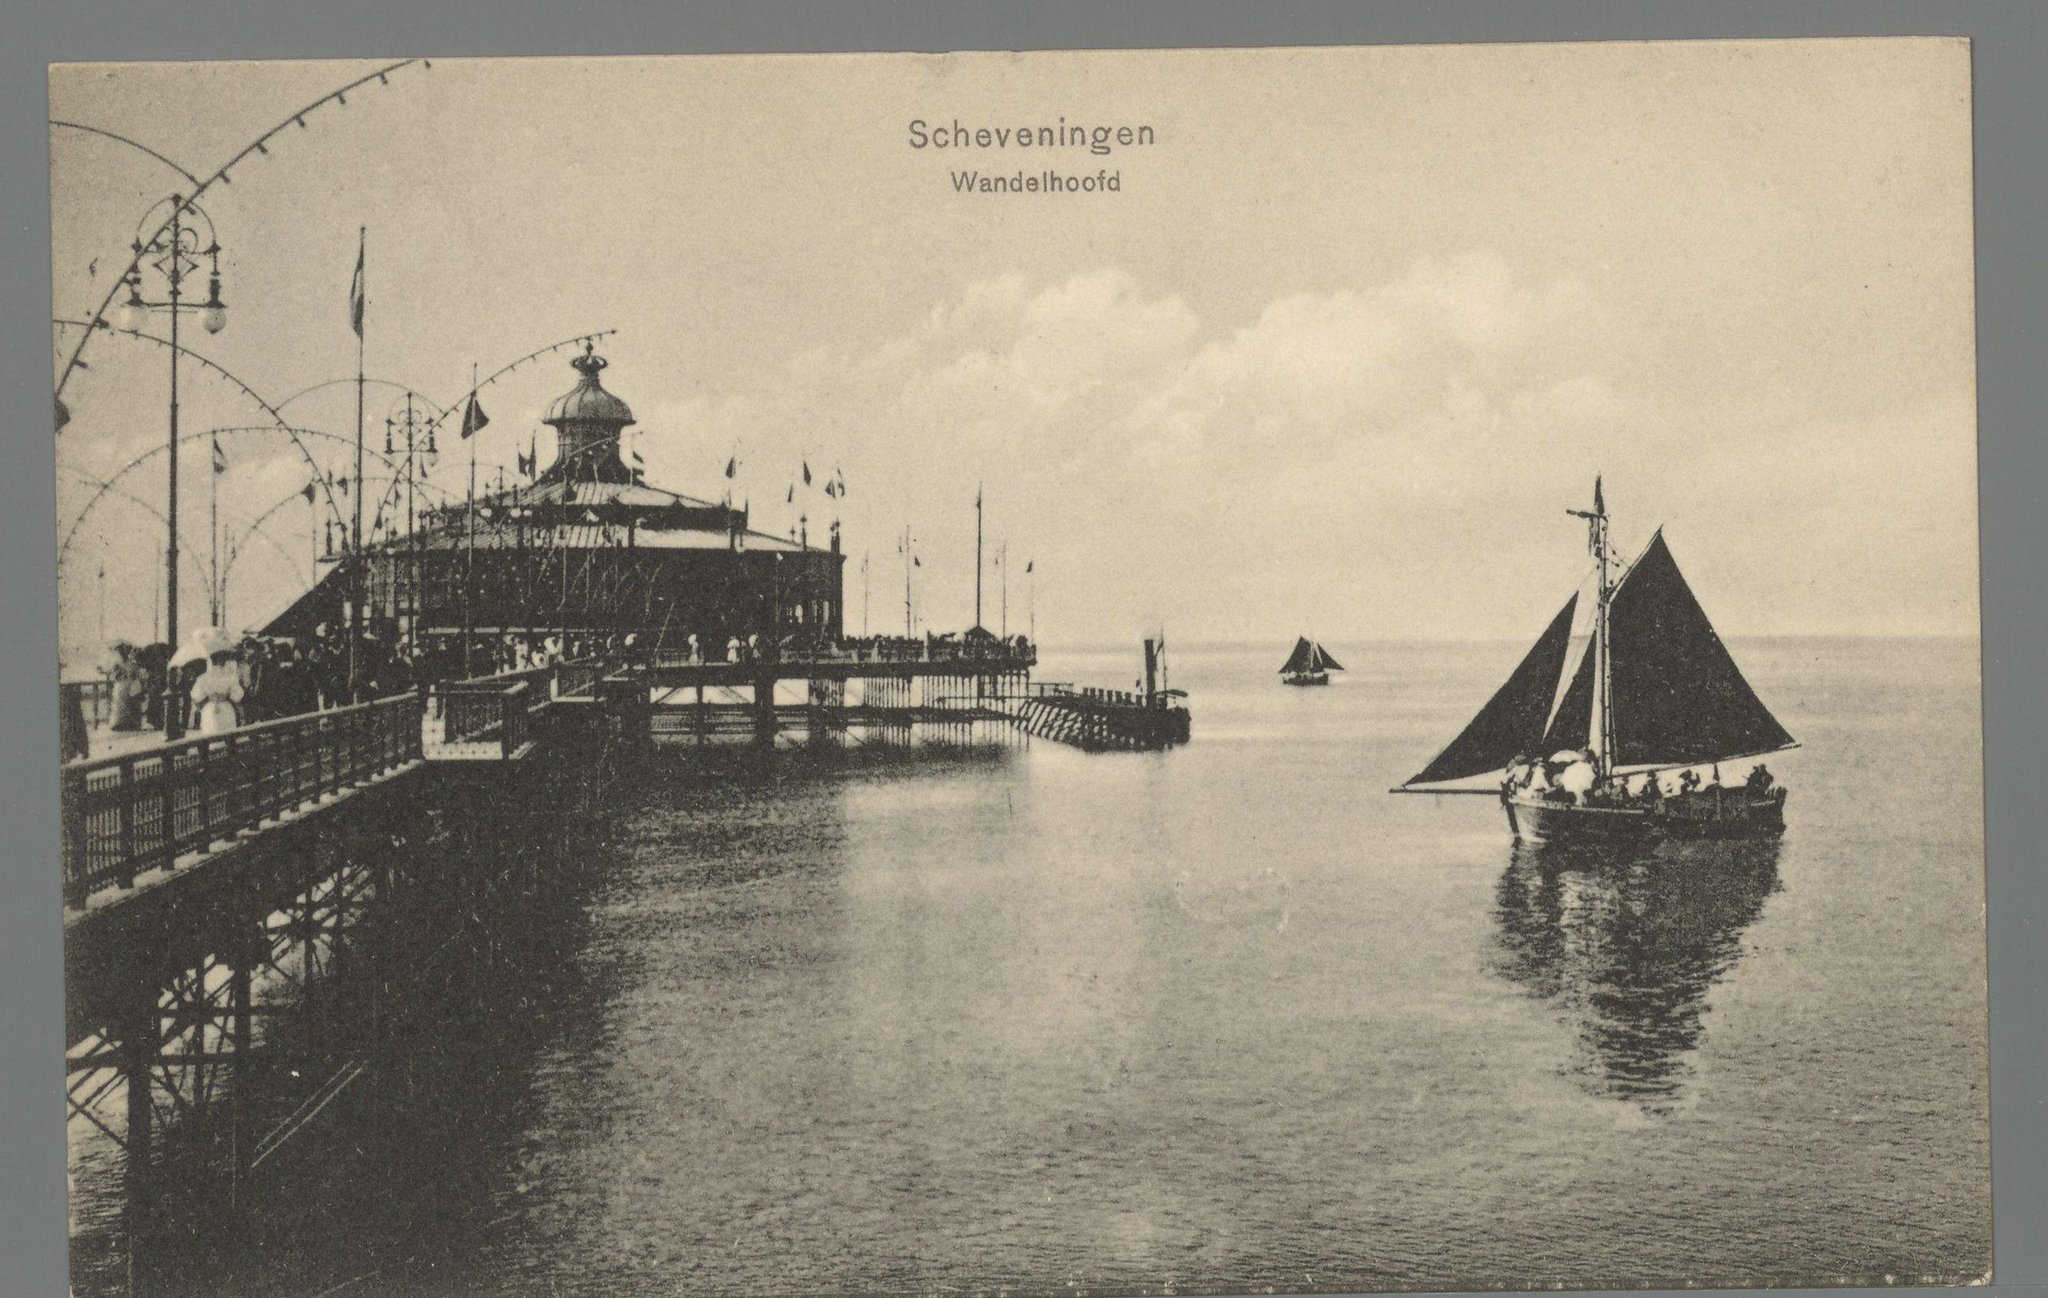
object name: ansichtkaart, prentbriefkaart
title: Scheveningen. Wandelhoofd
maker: Anonymous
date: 1912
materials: cardboard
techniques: photograph, writing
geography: the hague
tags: sailing-ship, sailing-boat, pier, quay, wharf, sea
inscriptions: postage stamp